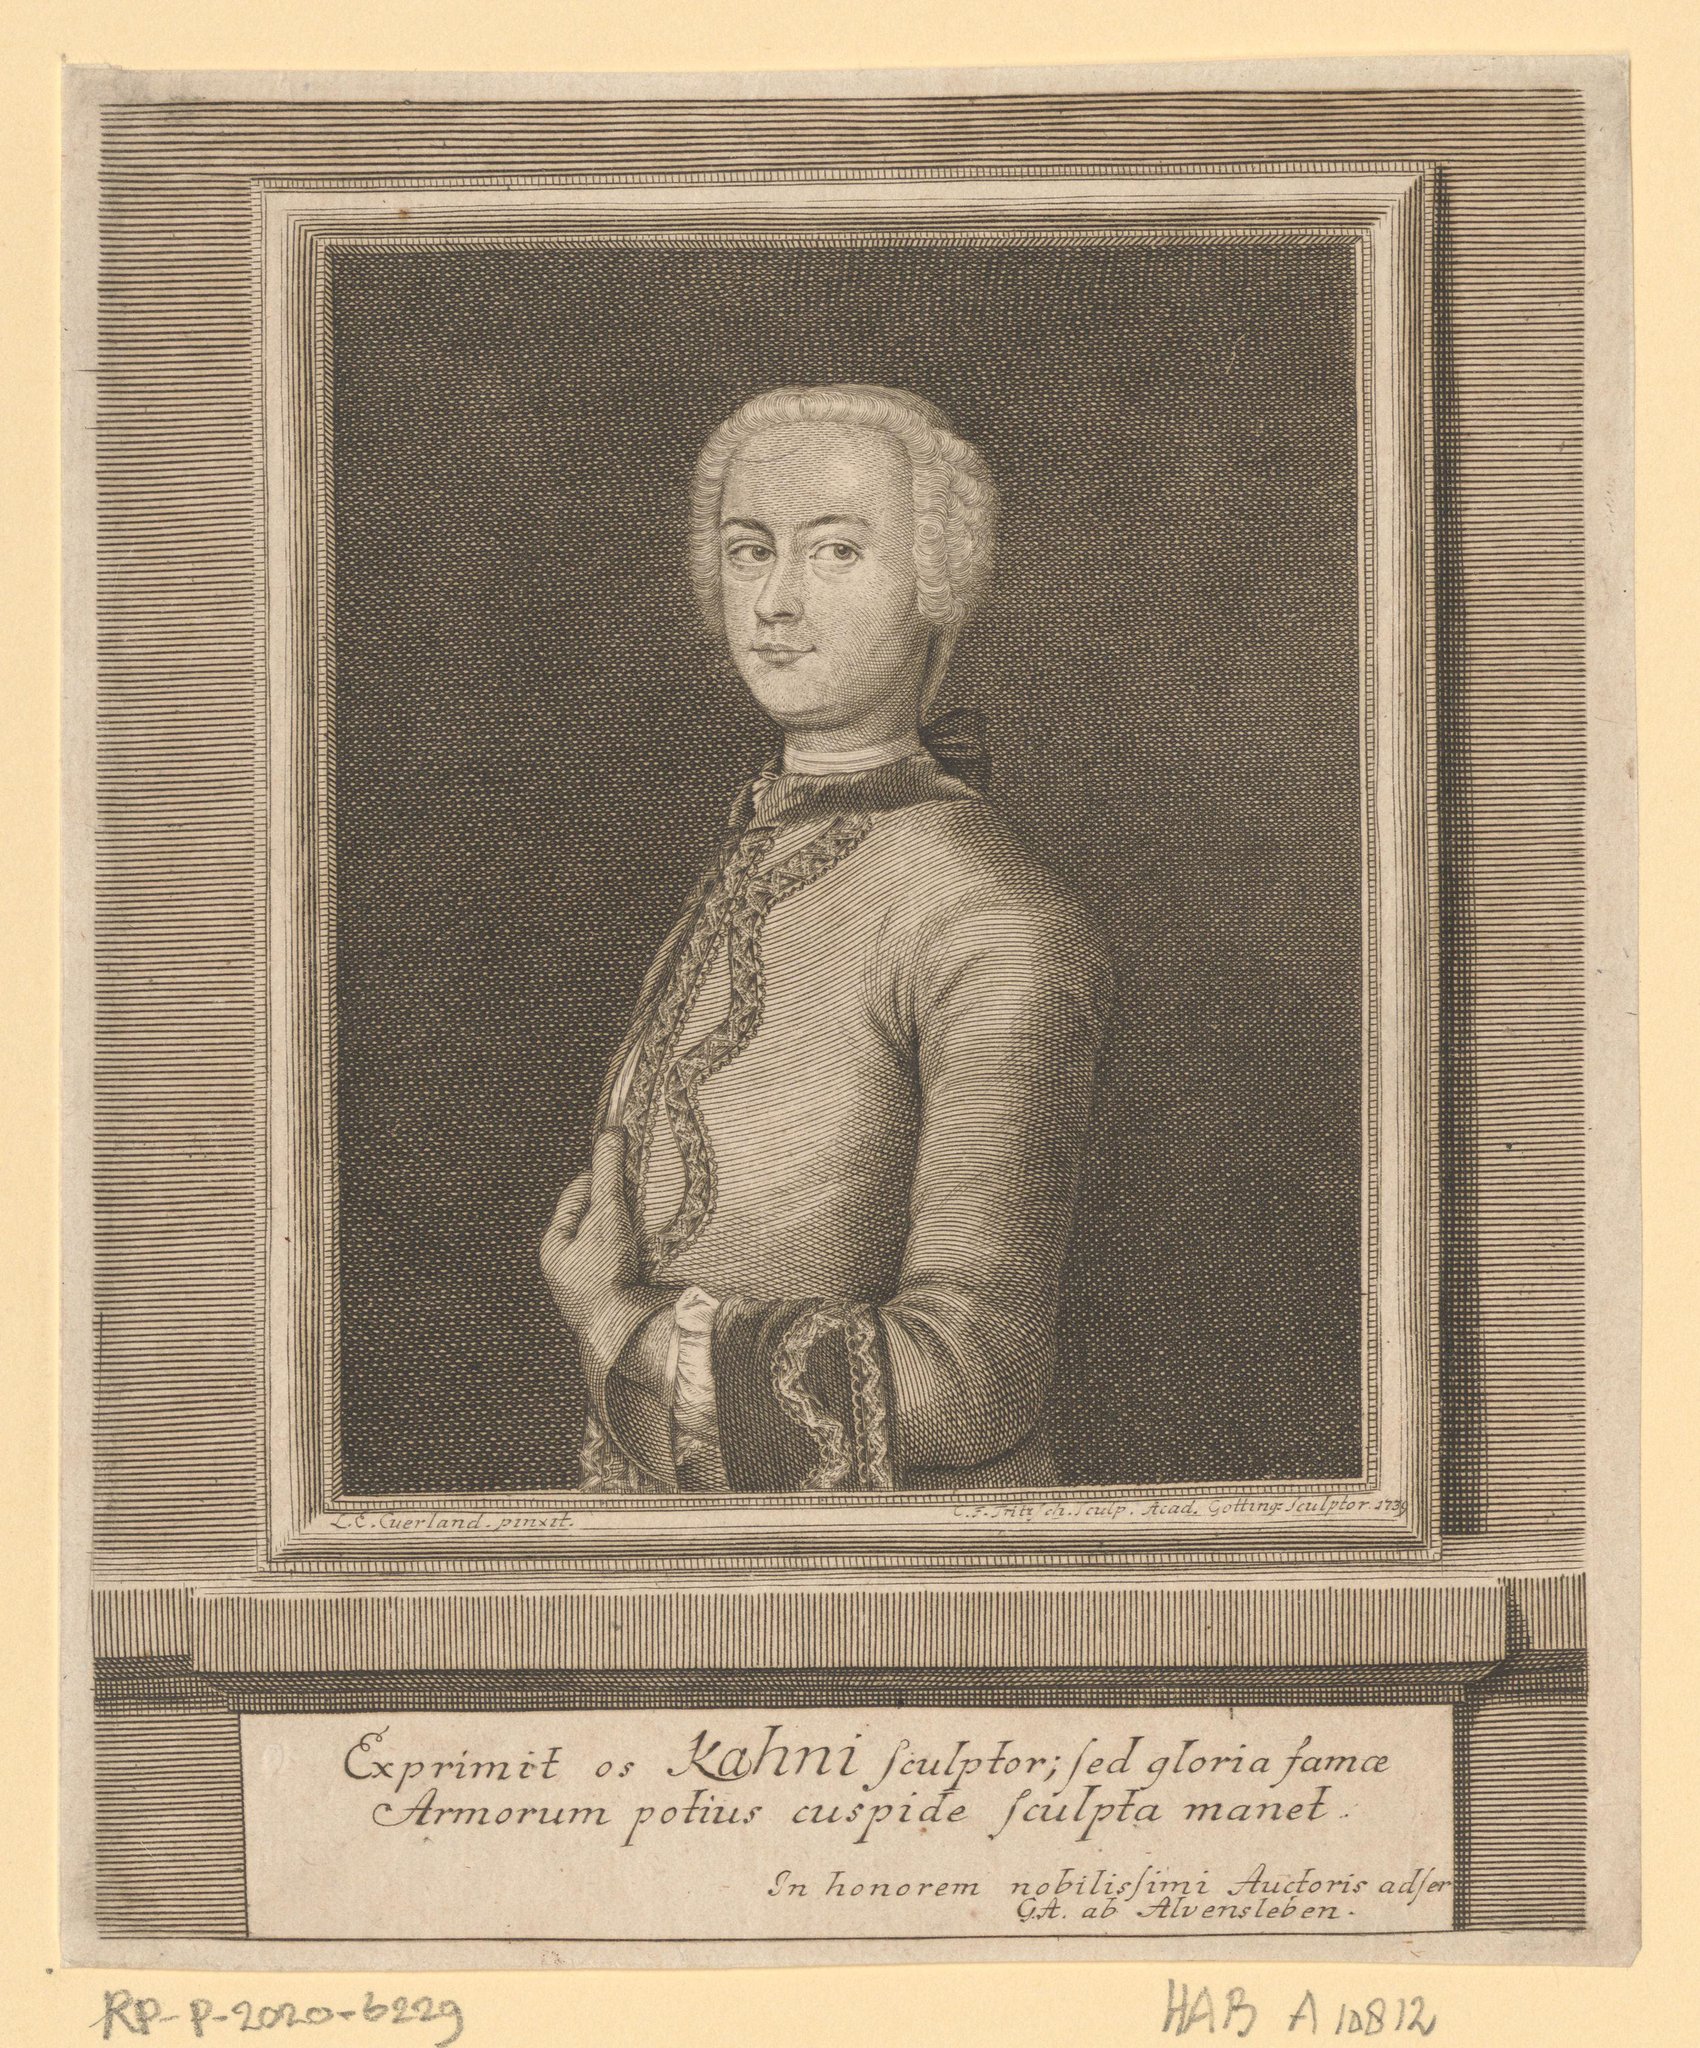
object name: print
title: Portret van Anton Friedrich Kahn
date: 1739-1761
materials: paper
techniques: engraving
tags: historical persons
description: Prent mogelijk uit: Kahn, Anton Friedrich. Anfangsgründe der Fechtkunst (...). Helmstedt: Christian Friedrich Weygand, 1761. Of een eerdere editie (1739).